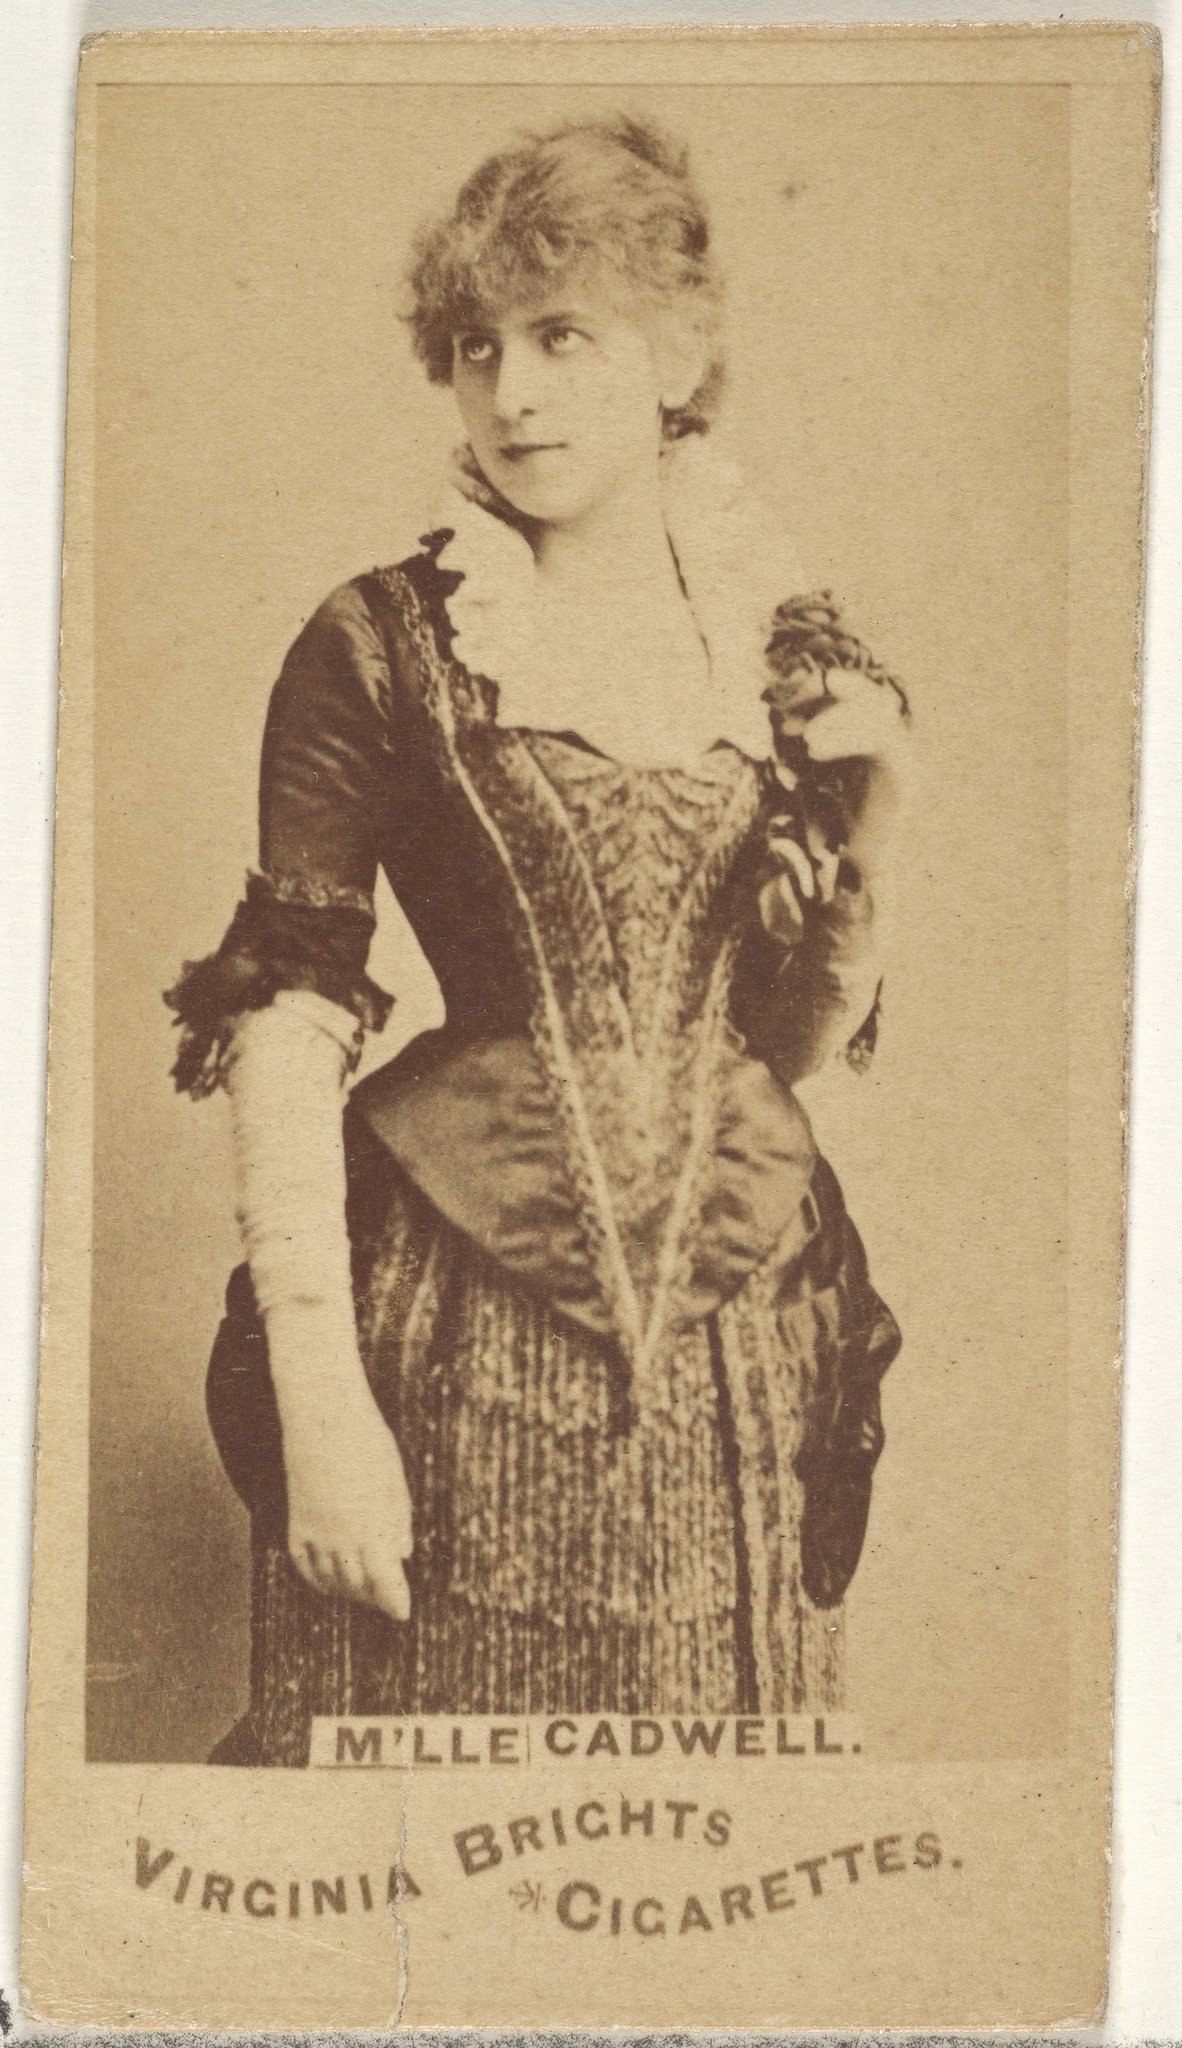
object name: photograph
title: Mlle. Cadwell, from the Actors and Actresses series (N45, Type 1) for Virginia Brights Cigarettes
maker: allen & ginter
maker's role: publisher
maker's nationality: american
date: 1888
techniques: albumen silver print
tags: portraits,women,actresses